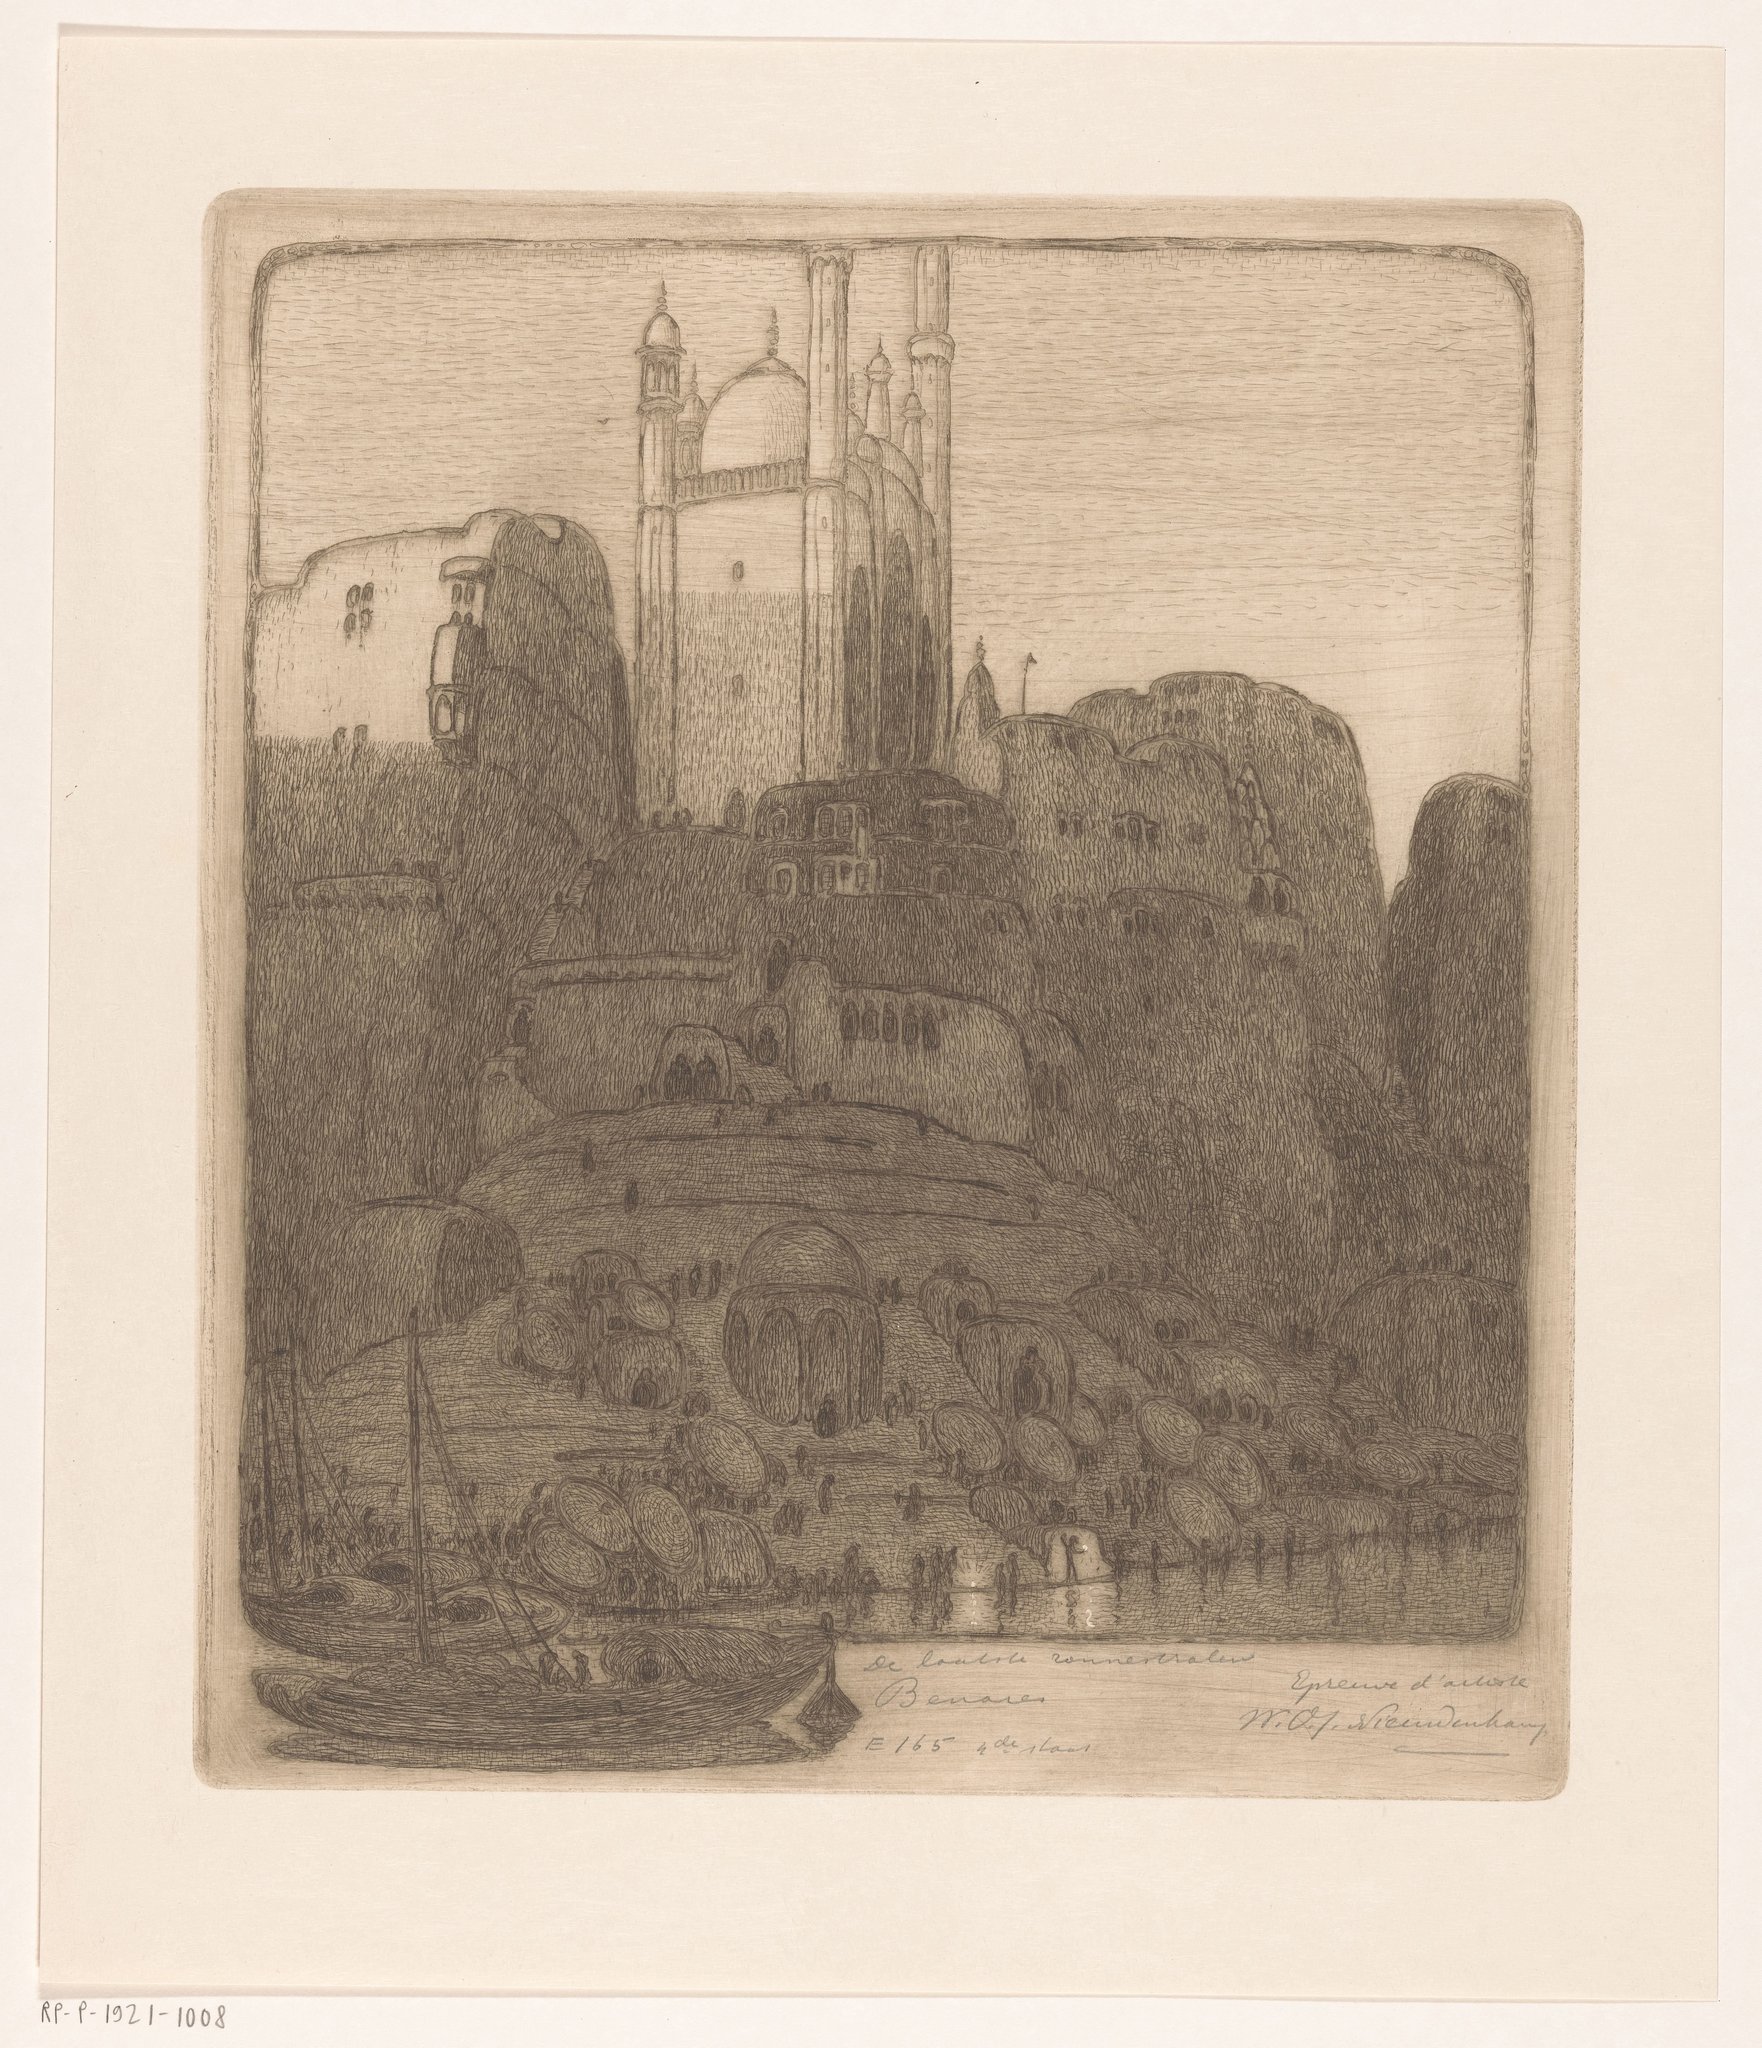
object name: print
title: De laatste zonnestralen, Benares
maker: wijnand otto jan nieuwenkamp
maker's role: draughtsman, print maker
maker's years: 1874-1950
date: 1915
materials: paper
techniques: etching, intaglio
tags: city-view in general; 'veduta', river, temple, shrine ~ islam, mohammedanism, sunset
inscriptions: collector's mark: Lugt 2233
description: De oever van de Ganges in Benares tijdens zonsondergang. In het water enkele schepen. Op de oever stenen trappen en terrassen. Bovenaan de Aurangzeb-moskee, ook bekend als de Alamgir-moskee.